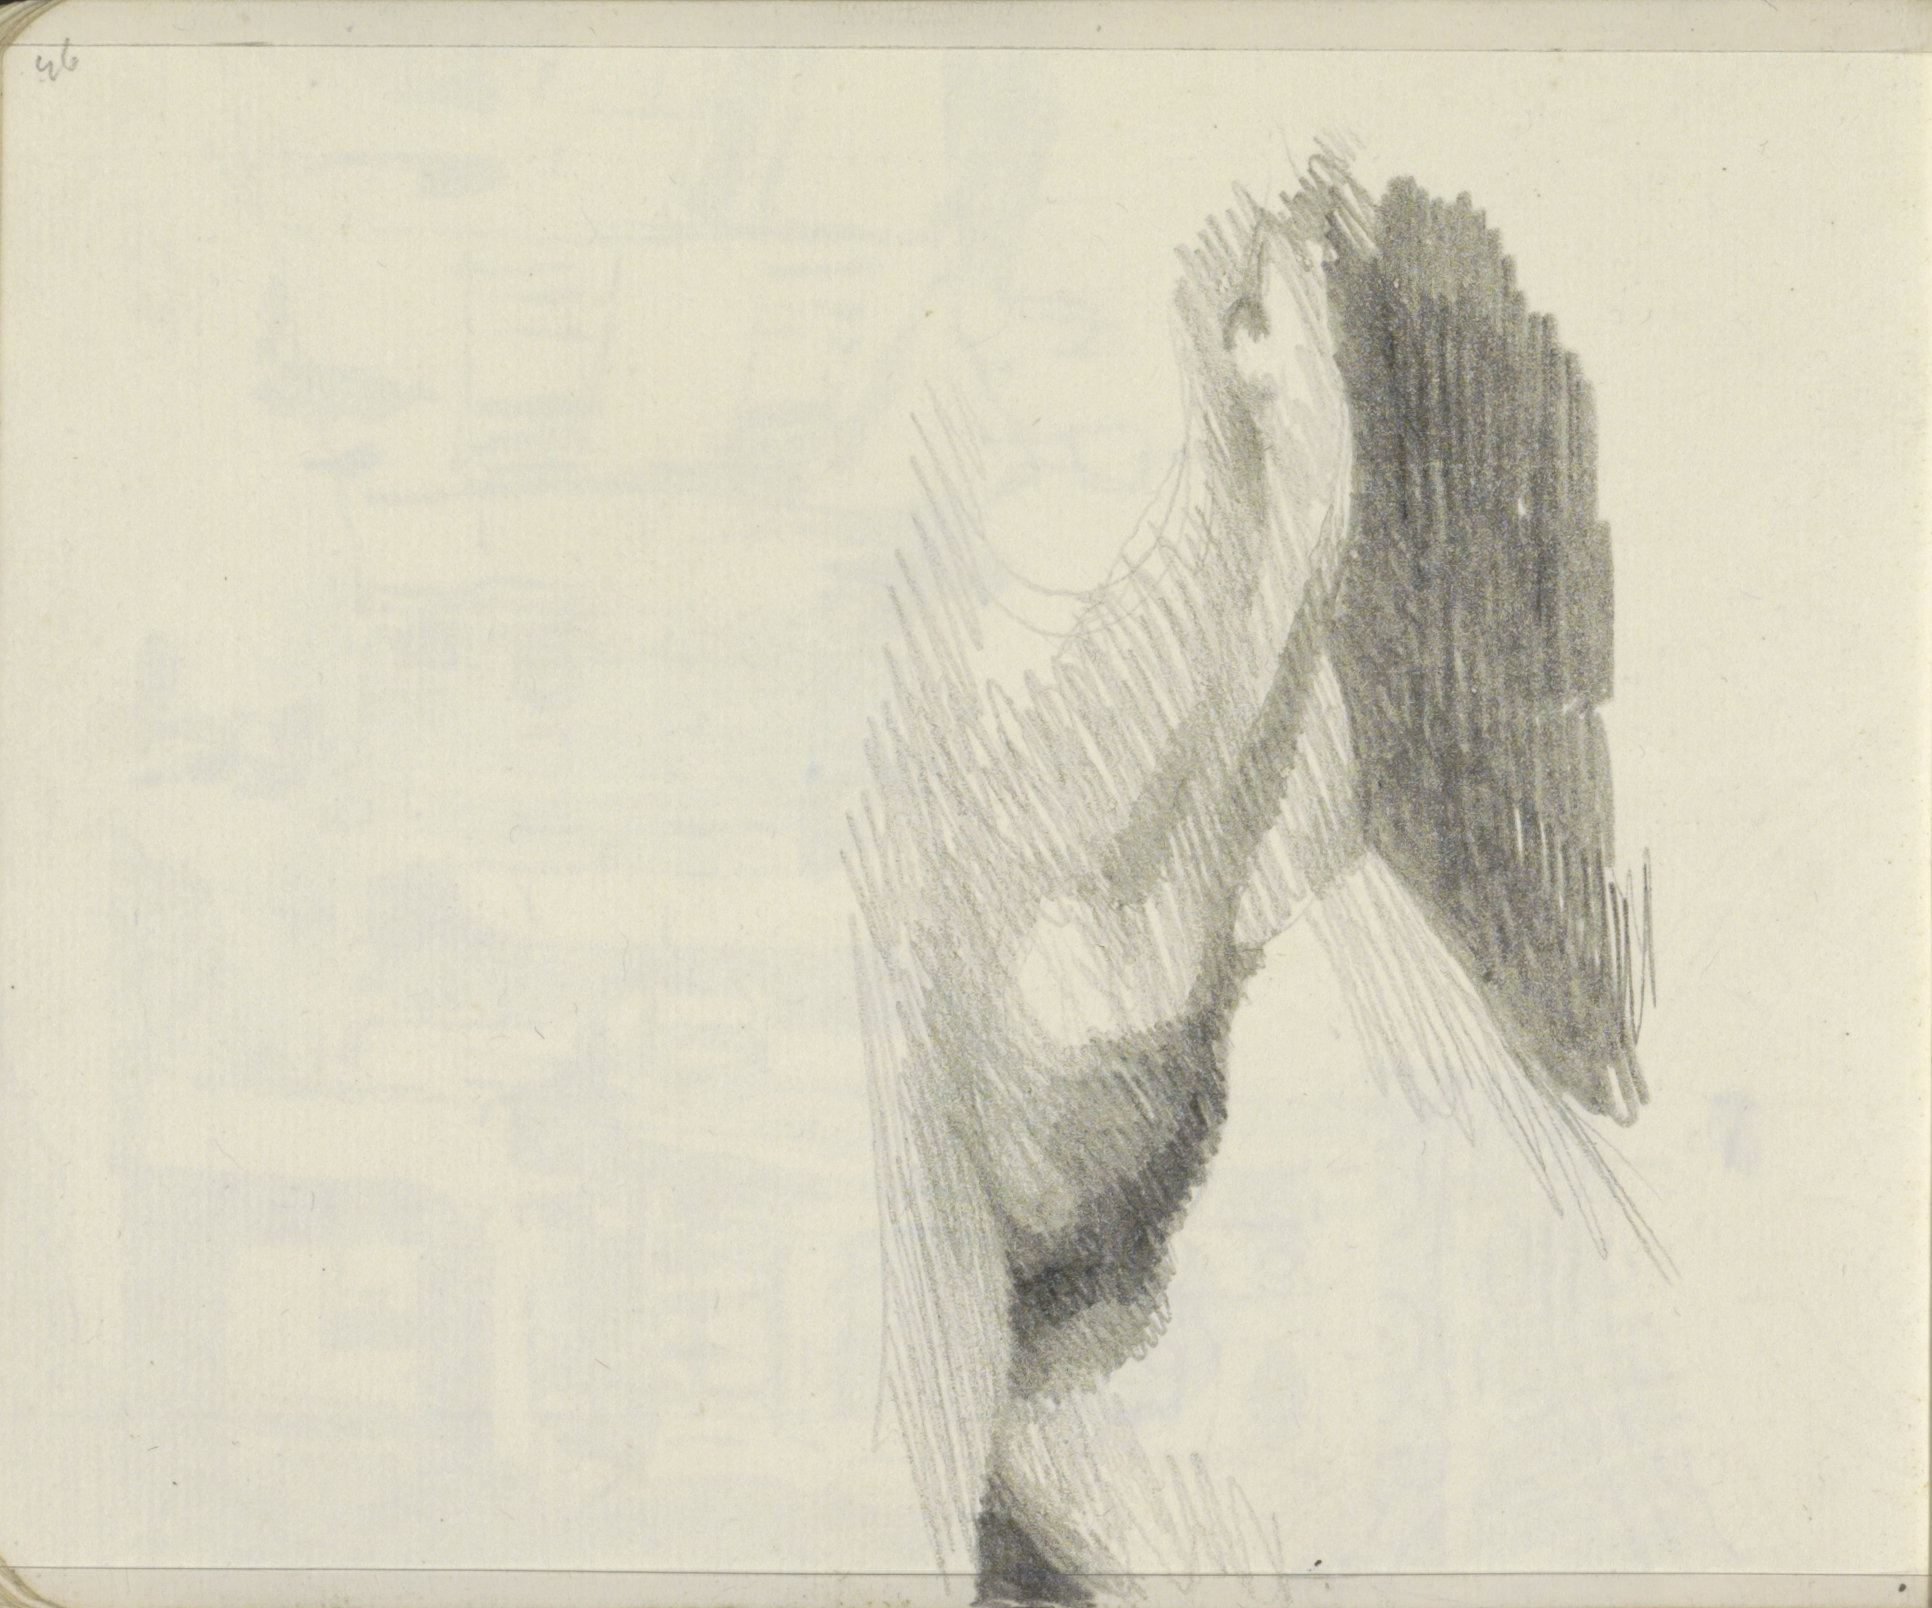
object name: sketchbook leaf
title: Landschap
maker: willem witsen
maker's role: draughtsman, painter, print maker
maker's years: 1860-1923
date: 1914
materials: paper, pencil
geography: venice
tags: landscapes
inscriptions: watermark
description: Pagina 46 uit een schetsboek met 26 bladen.